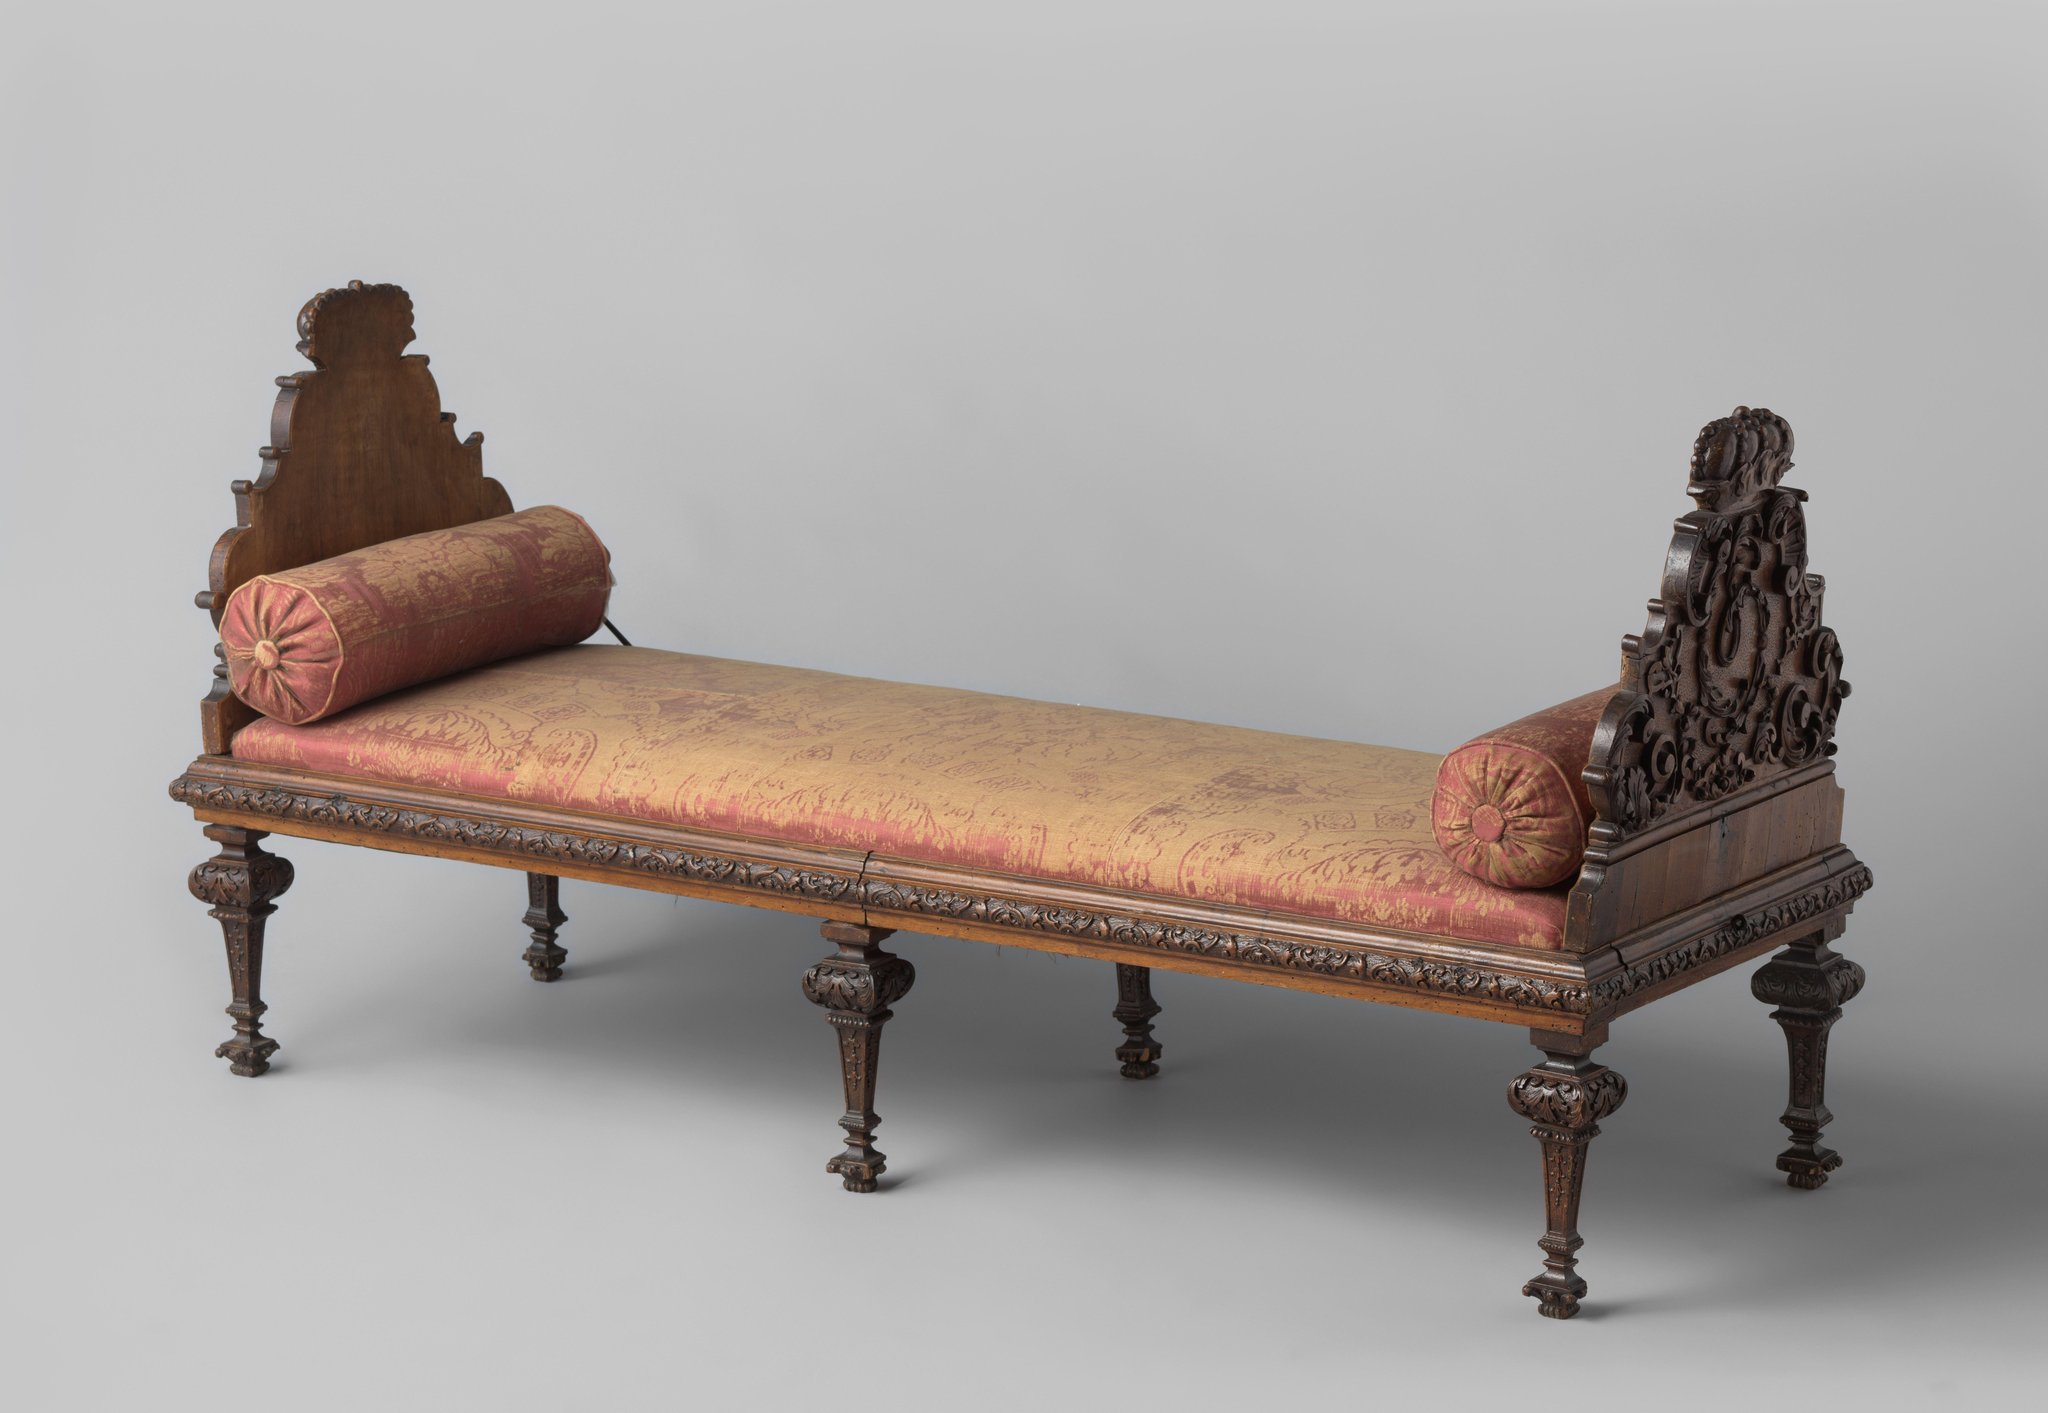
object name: bed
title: Bank, demontabel en versierd met de letters CH onder keurvorstenkroon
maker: Anonymous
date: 1745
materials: iron, wood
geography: lower rhine region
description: Folding bench. Walnut. Germany, c. 1700 - 1740.